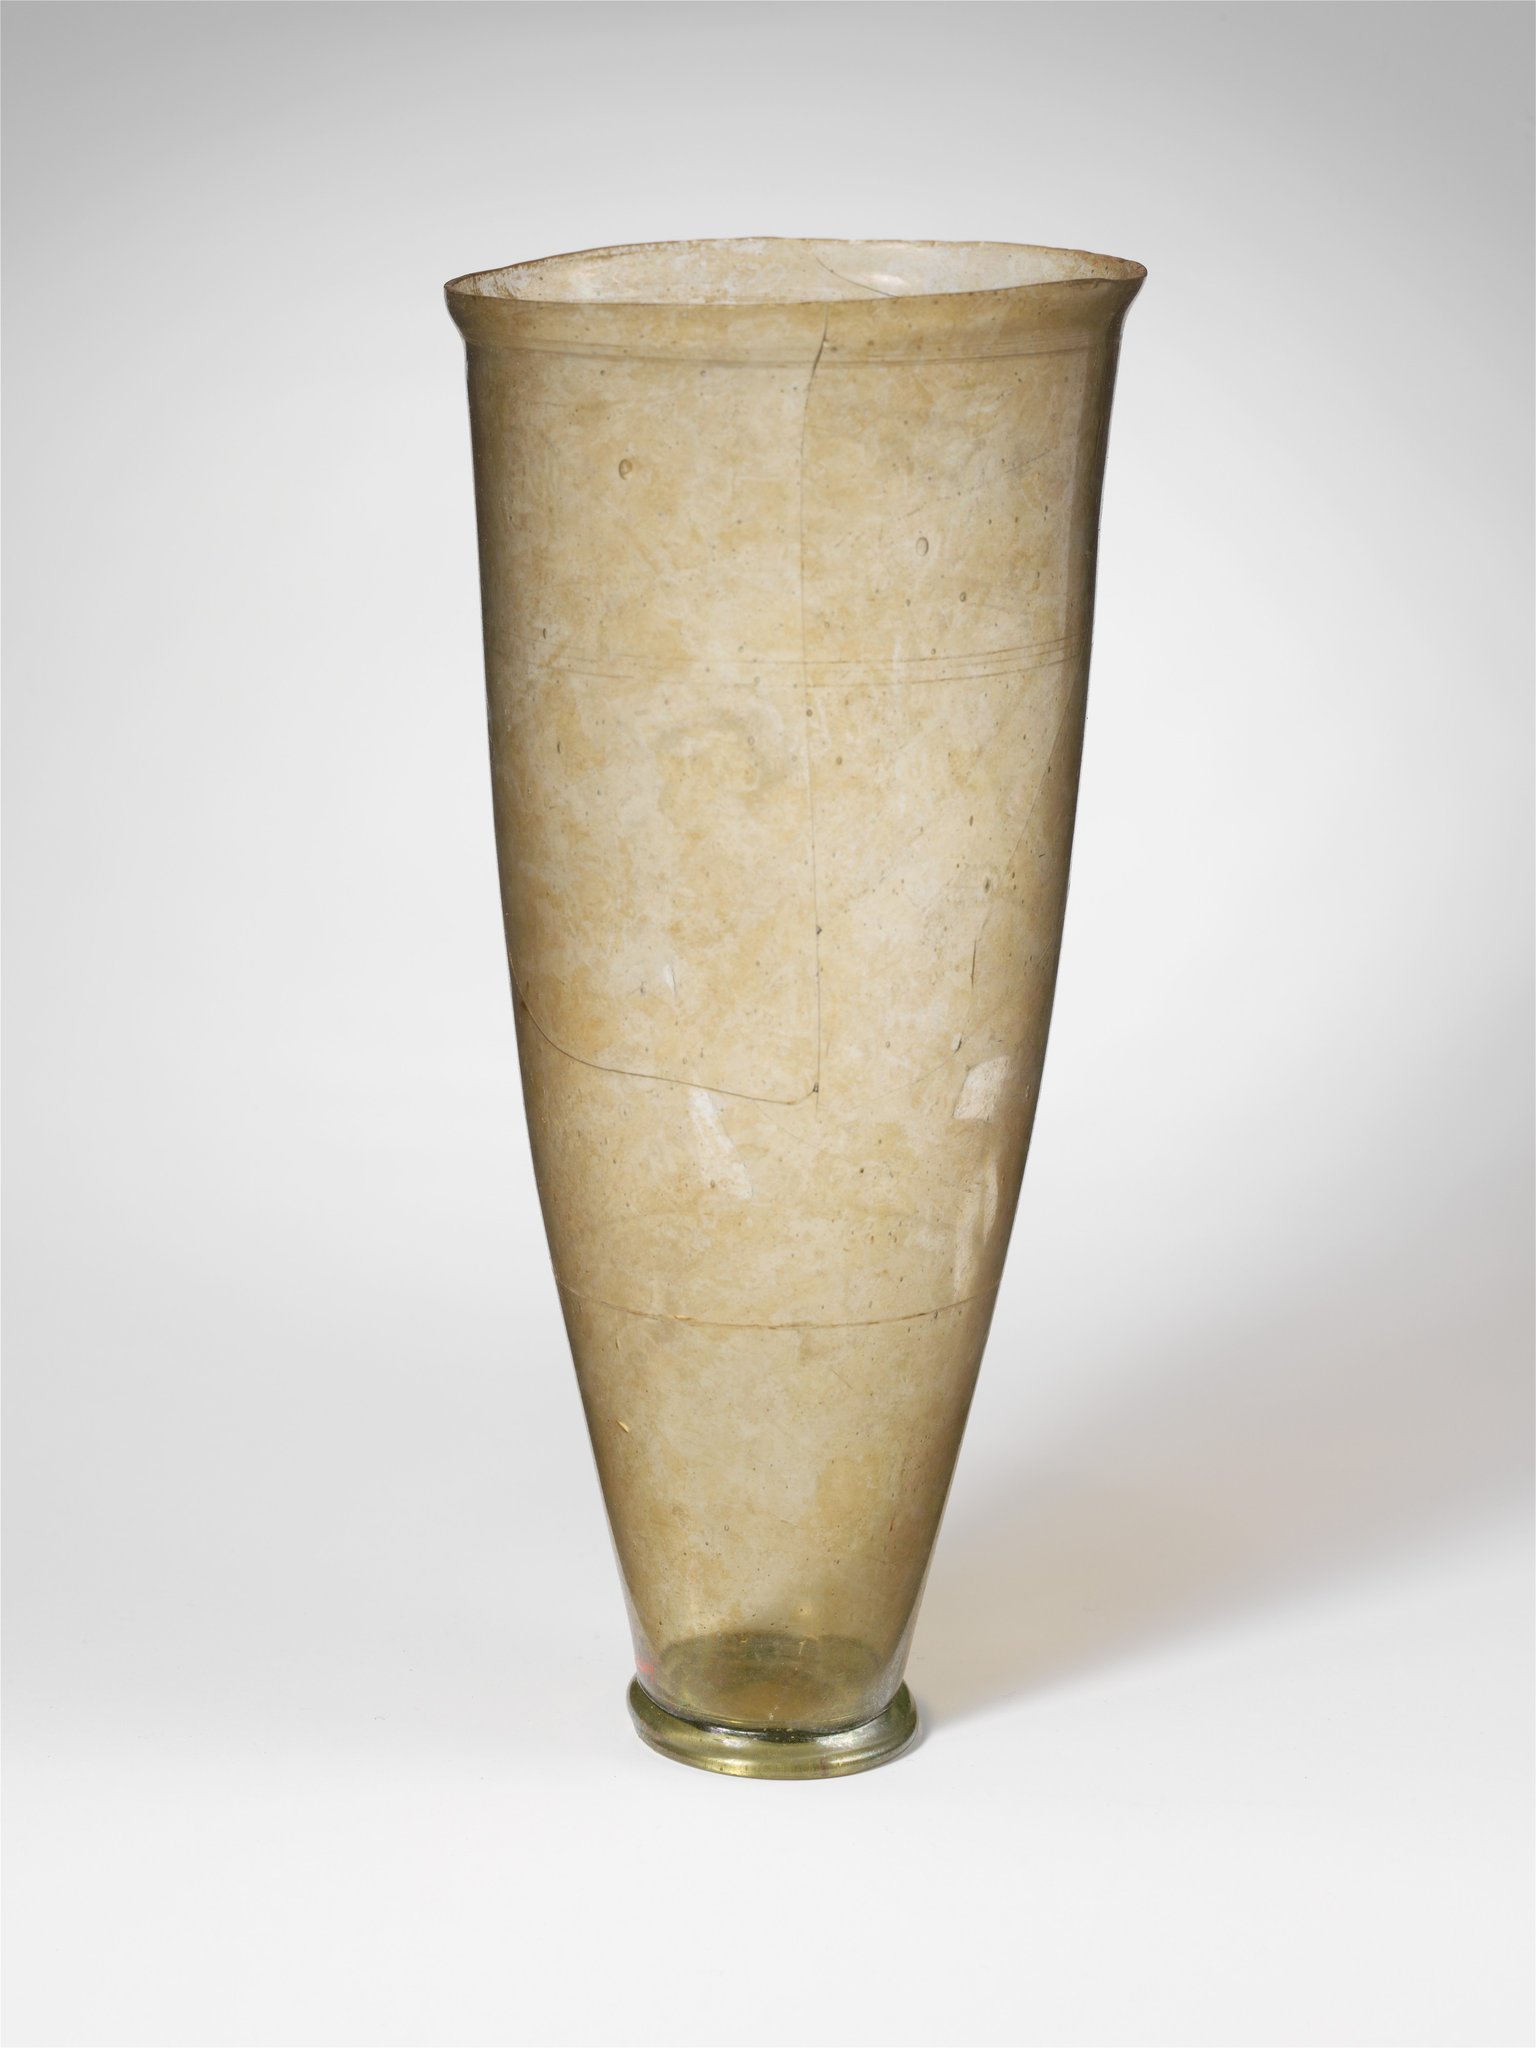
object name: beaker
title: Glass beaker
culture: roman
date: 201-400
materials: glass